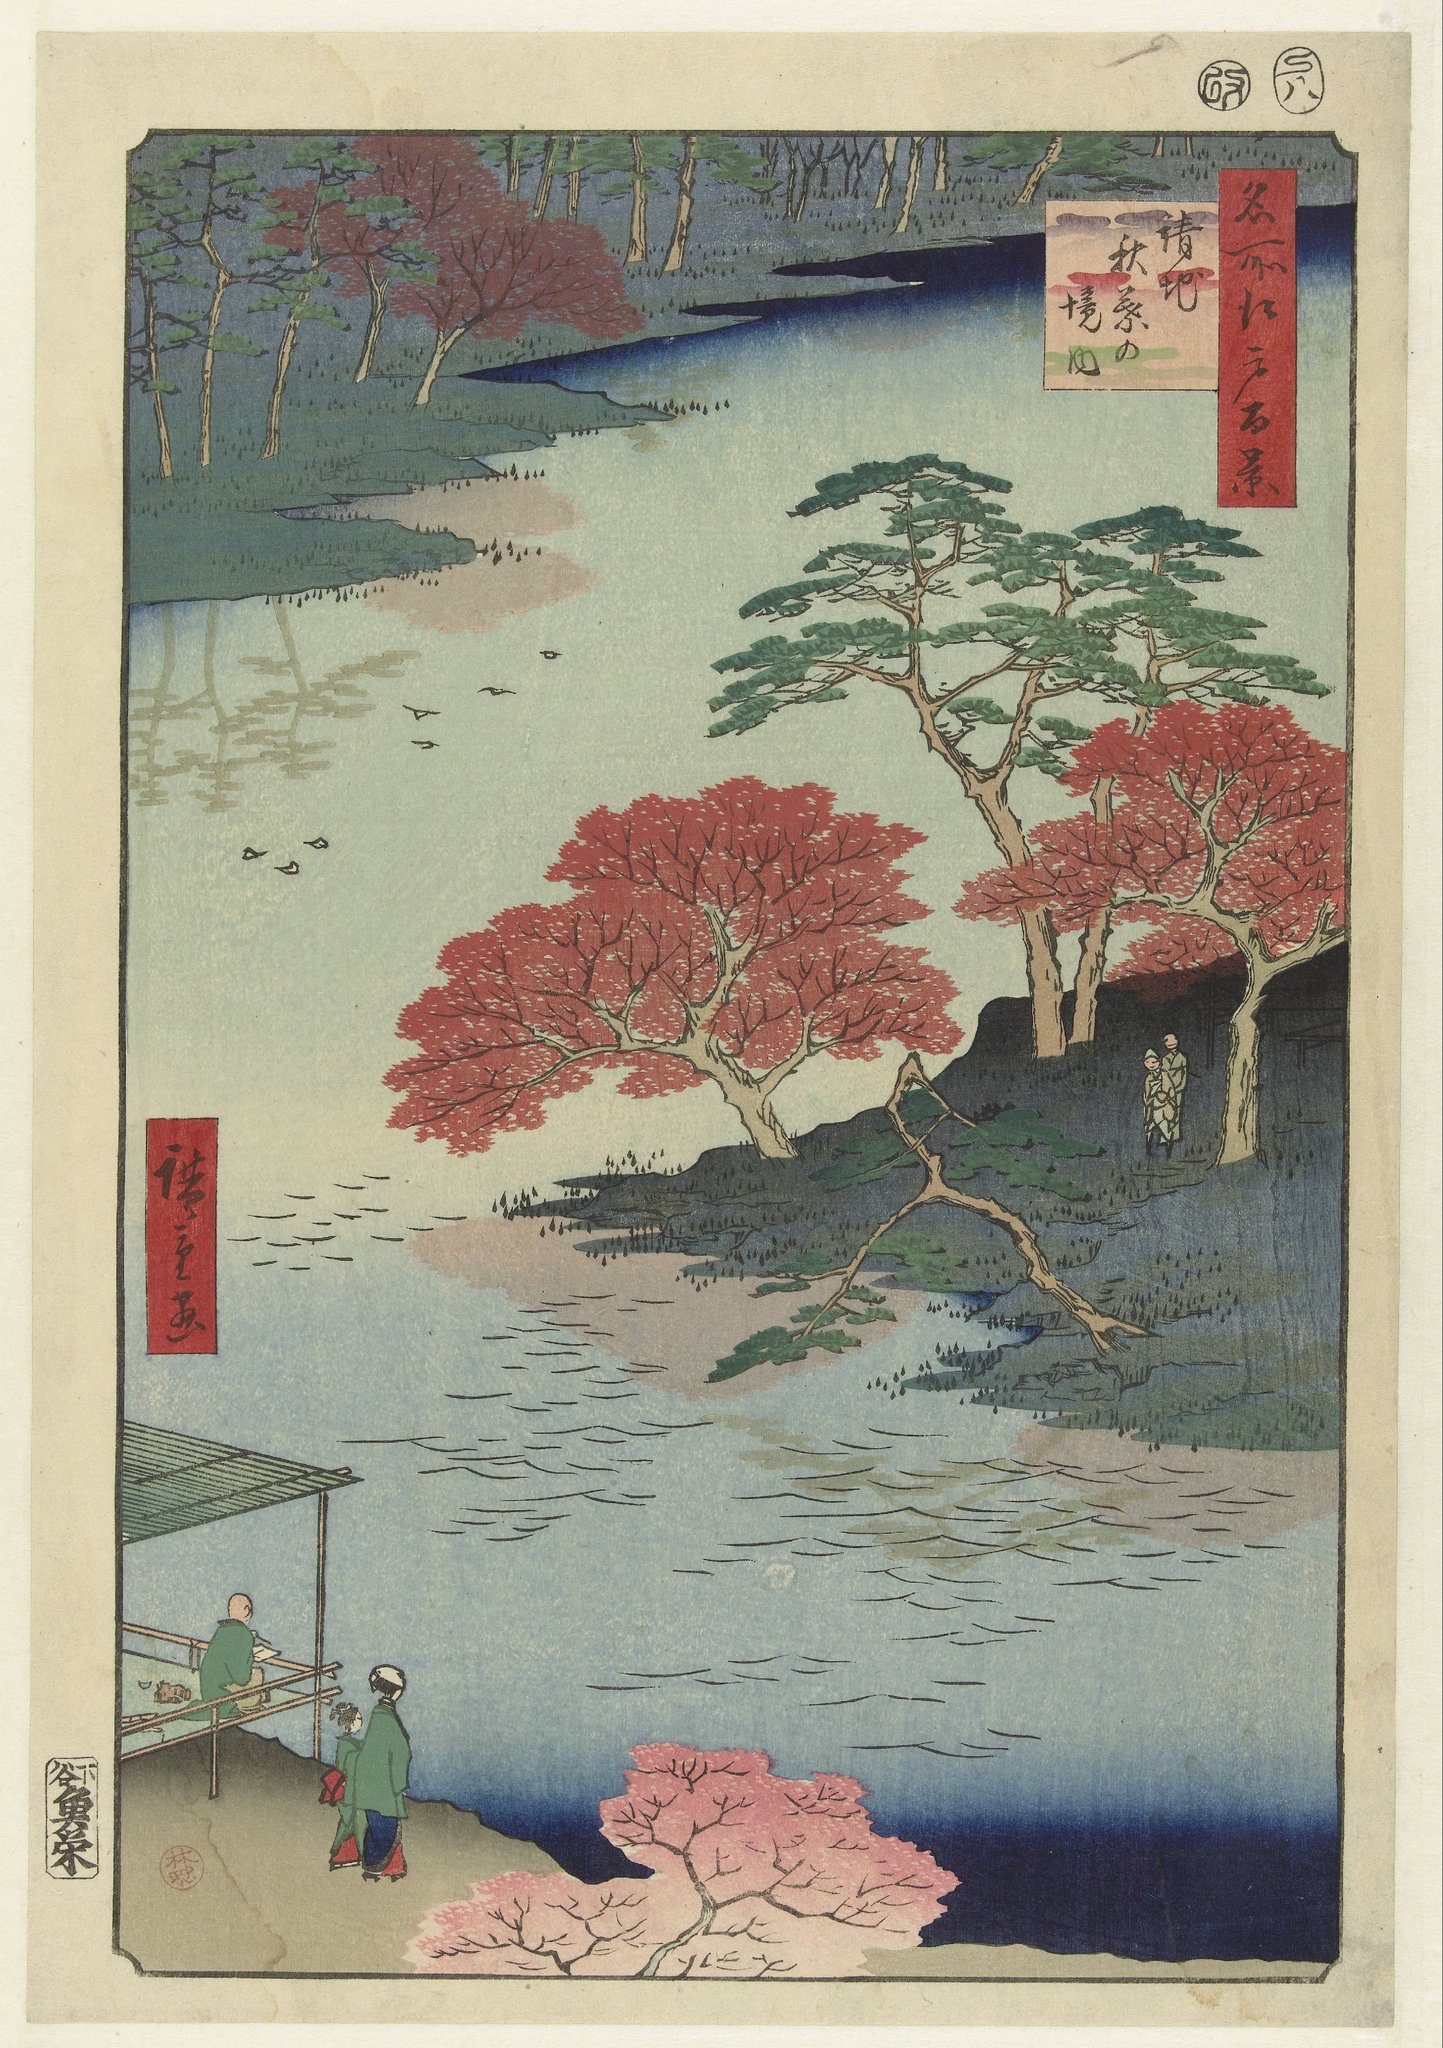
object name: print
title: Honderd beroemde gezichten op Edo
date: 1857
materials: paper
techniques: woodcut, nishiki e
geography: tokyo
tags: autumn landscape; landscape symbolizing autumn (the four seasons of the year)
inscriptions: collector's mark: Lugt 2228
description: Gezicht in vogelperspectief op een park met water en bomen in herfstkleuren. Op de voorgrond staan twee vrouwen naast een veranda waar een man zittend aan het tekenen is.